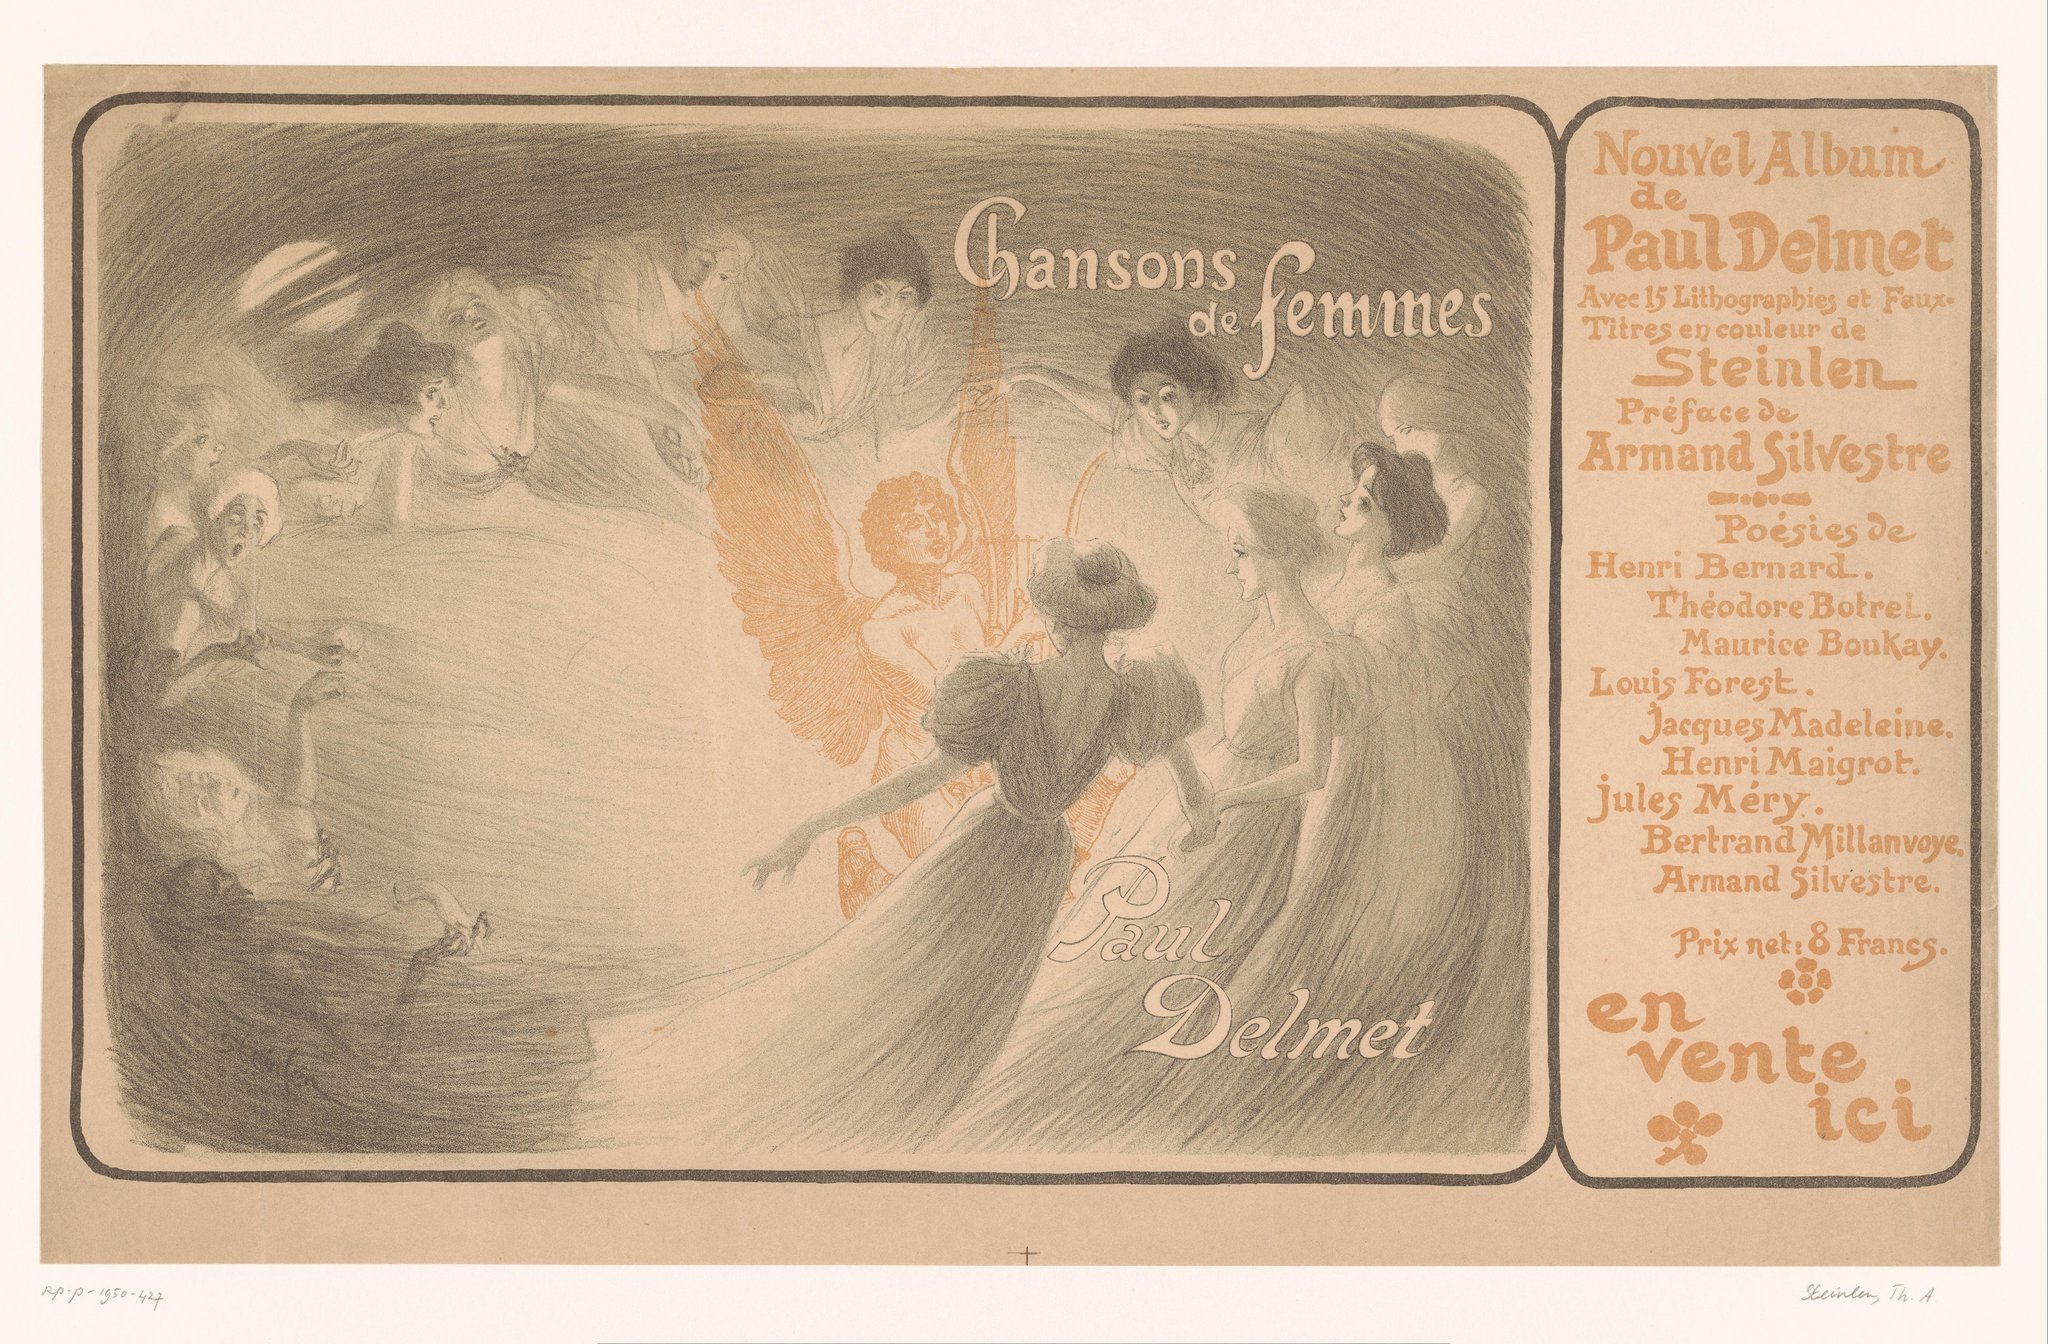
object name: print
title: Zingende engel omringd door vrouwen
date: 1897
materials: paper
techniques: lithograph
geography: paris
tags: angels singing, making music, choir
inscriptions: collector's mark: Lugt 2228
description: De prent diende als reclameposter voor een album met lithografieën en poëzie.